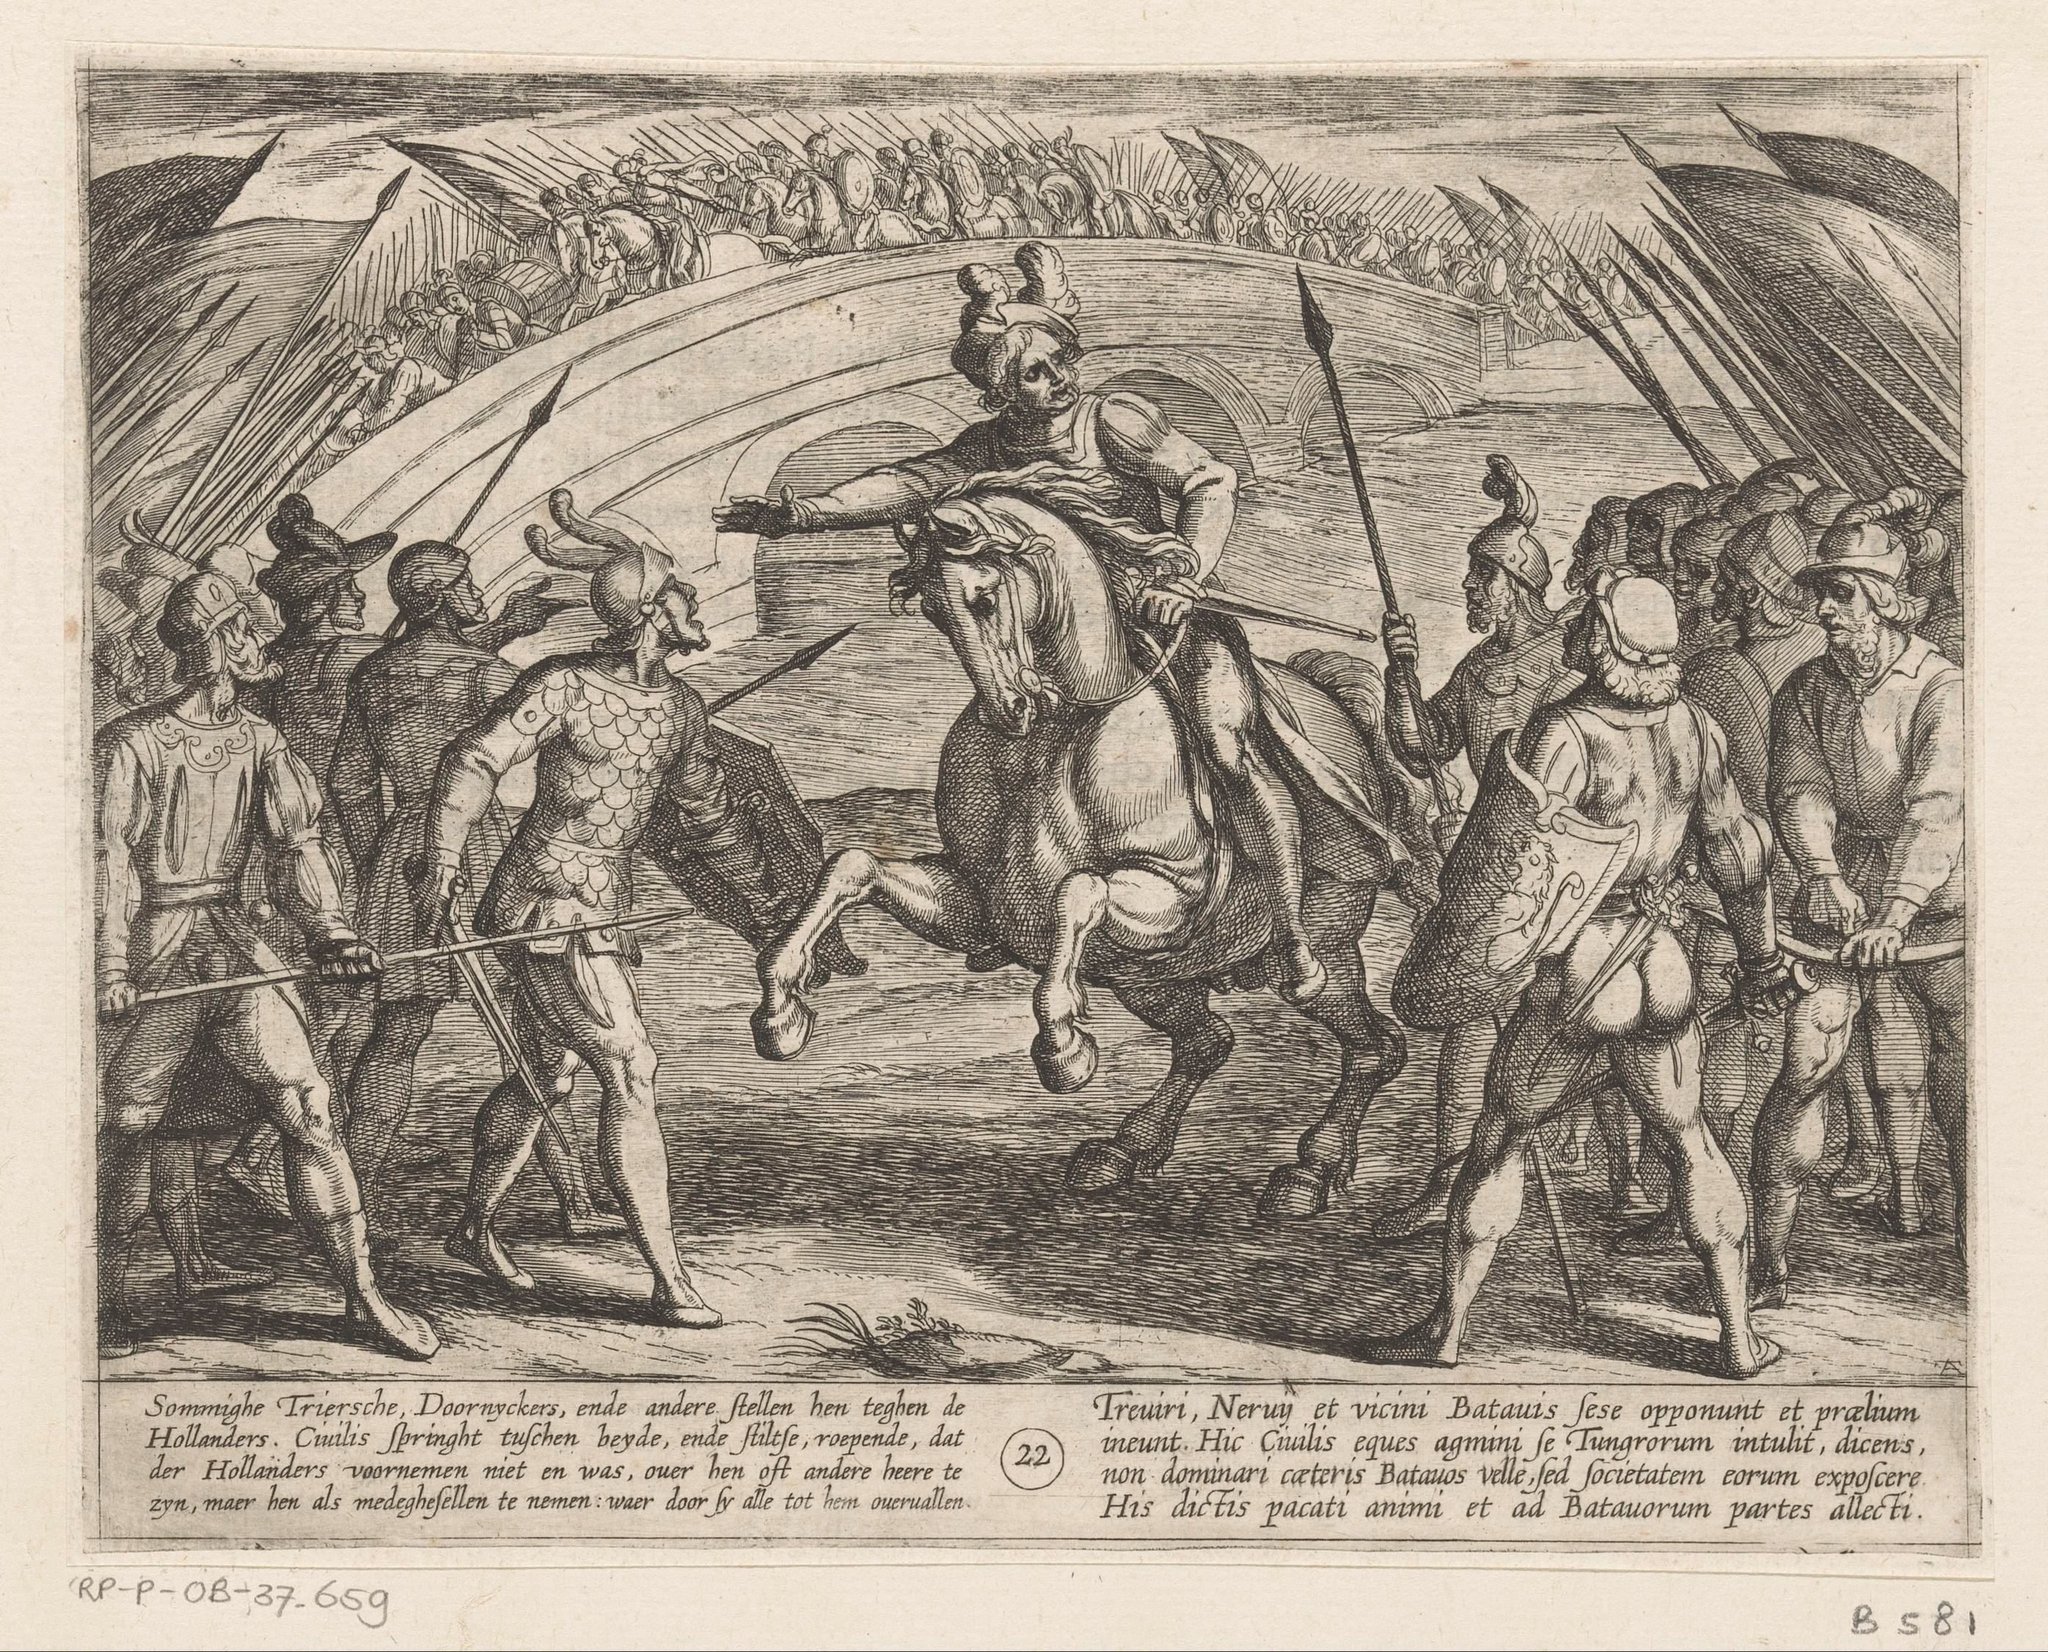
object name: print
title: De Bataafse oorlogen tegen de Romeinen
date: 1611-1612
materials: paper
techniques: etching, letterpress printing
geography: antwerp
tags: the soldier; the soldier's life, (story of) julius claudius civilis, extinct, 'historical' peoples (with name)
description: Julius Civilis zit te paard en scheidt de Duitse en Nederlandse troepen van elkaar. Op de achtergrond staan soldaten op een brug. Onderschrift in het Nederlands en in het Latijn.